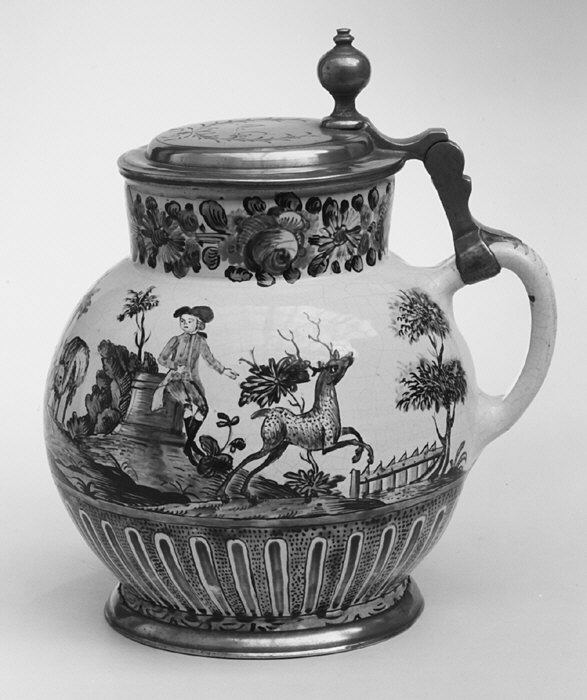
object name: tankard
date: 1701-1800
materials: earthenware, pewter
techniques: glazing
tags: men,deer,flowers,trees